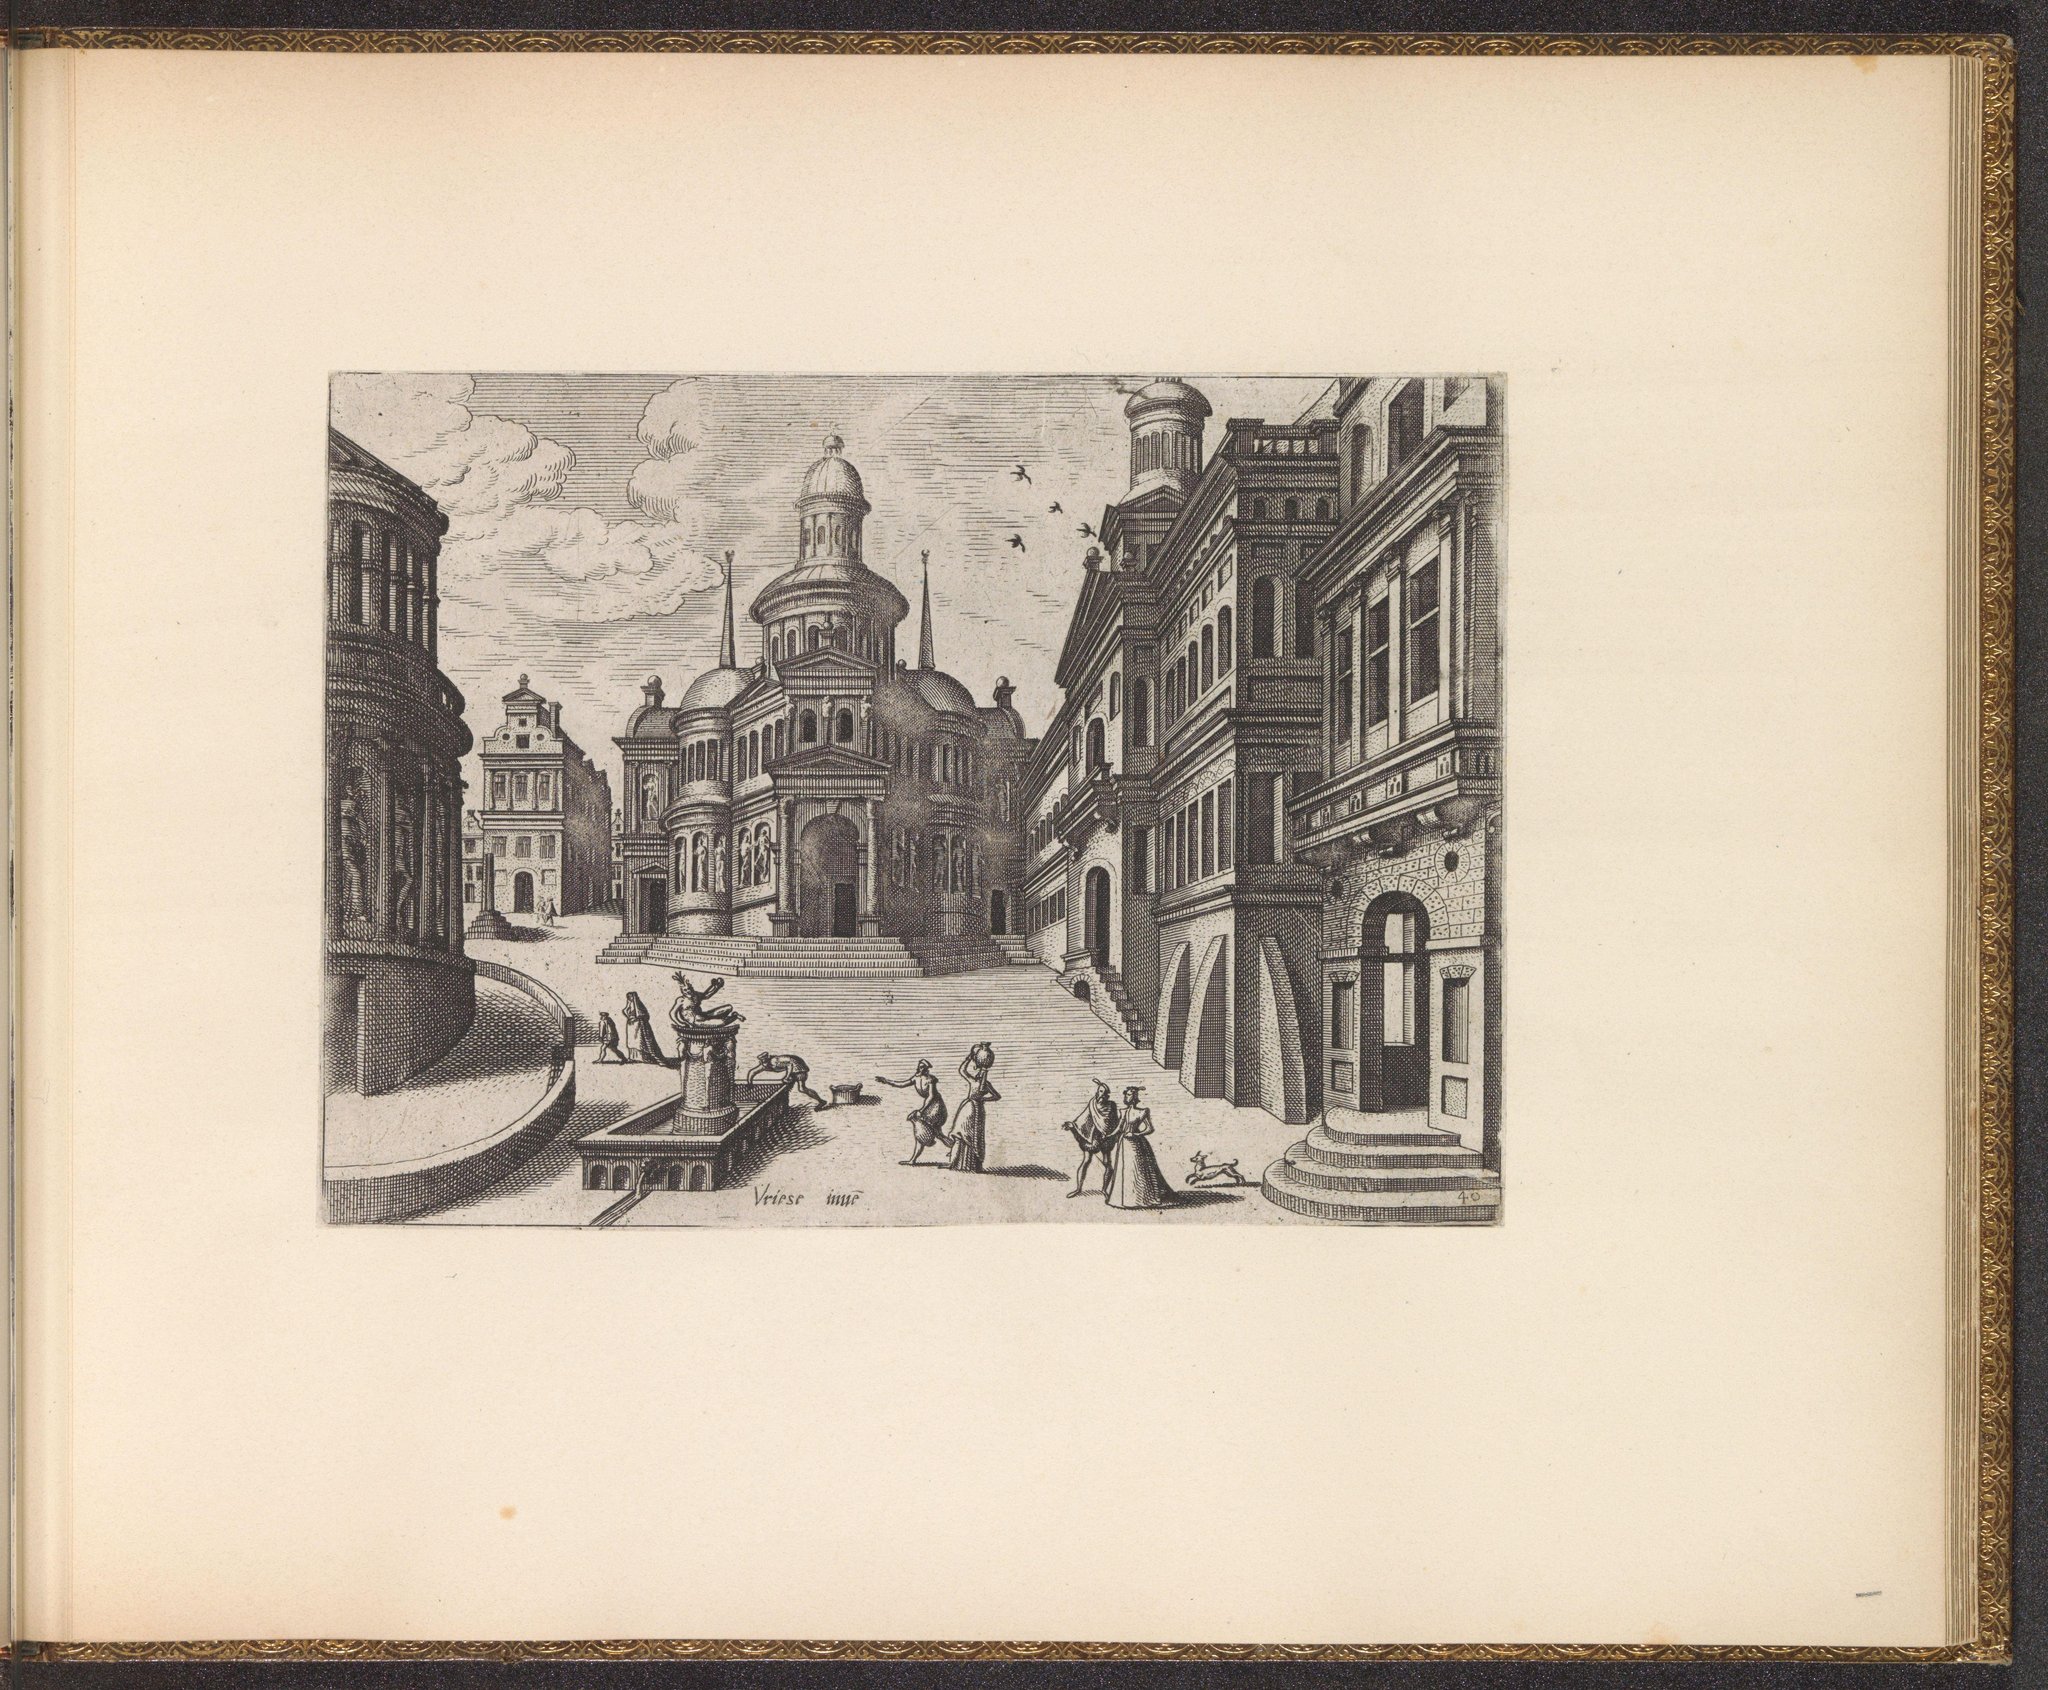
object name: album leaf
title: Architectuurperspectieven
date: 1601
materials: paper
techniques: etching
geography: antwerp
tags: square, place, circus, etc., ornamental fountain (in village)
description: Plein met een fontein op de voorgrond. Achteraan ligt op een verhoging een koepelkerk, gedecoreerd met beelden in nissen. Op de voorgrond staan enkele personen met waterkruiken. De prent maakt deel uit van een album.